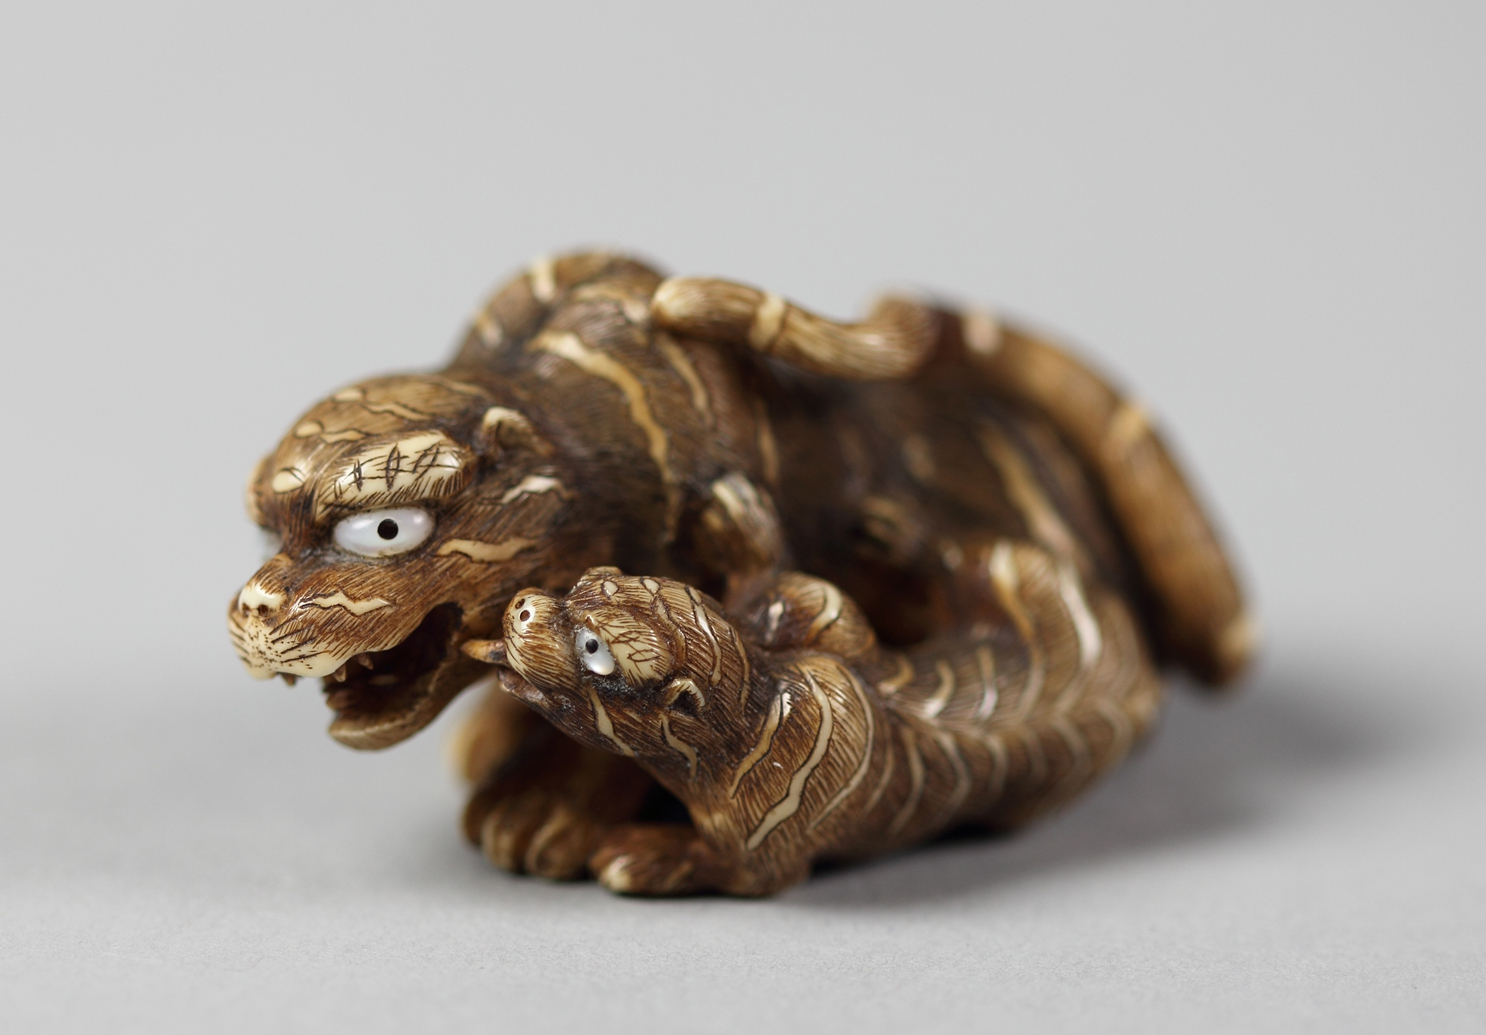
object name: netsuke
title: Netsuke of Tiger and Cub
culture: japanese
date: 1701-1800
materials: ivory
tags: tigers